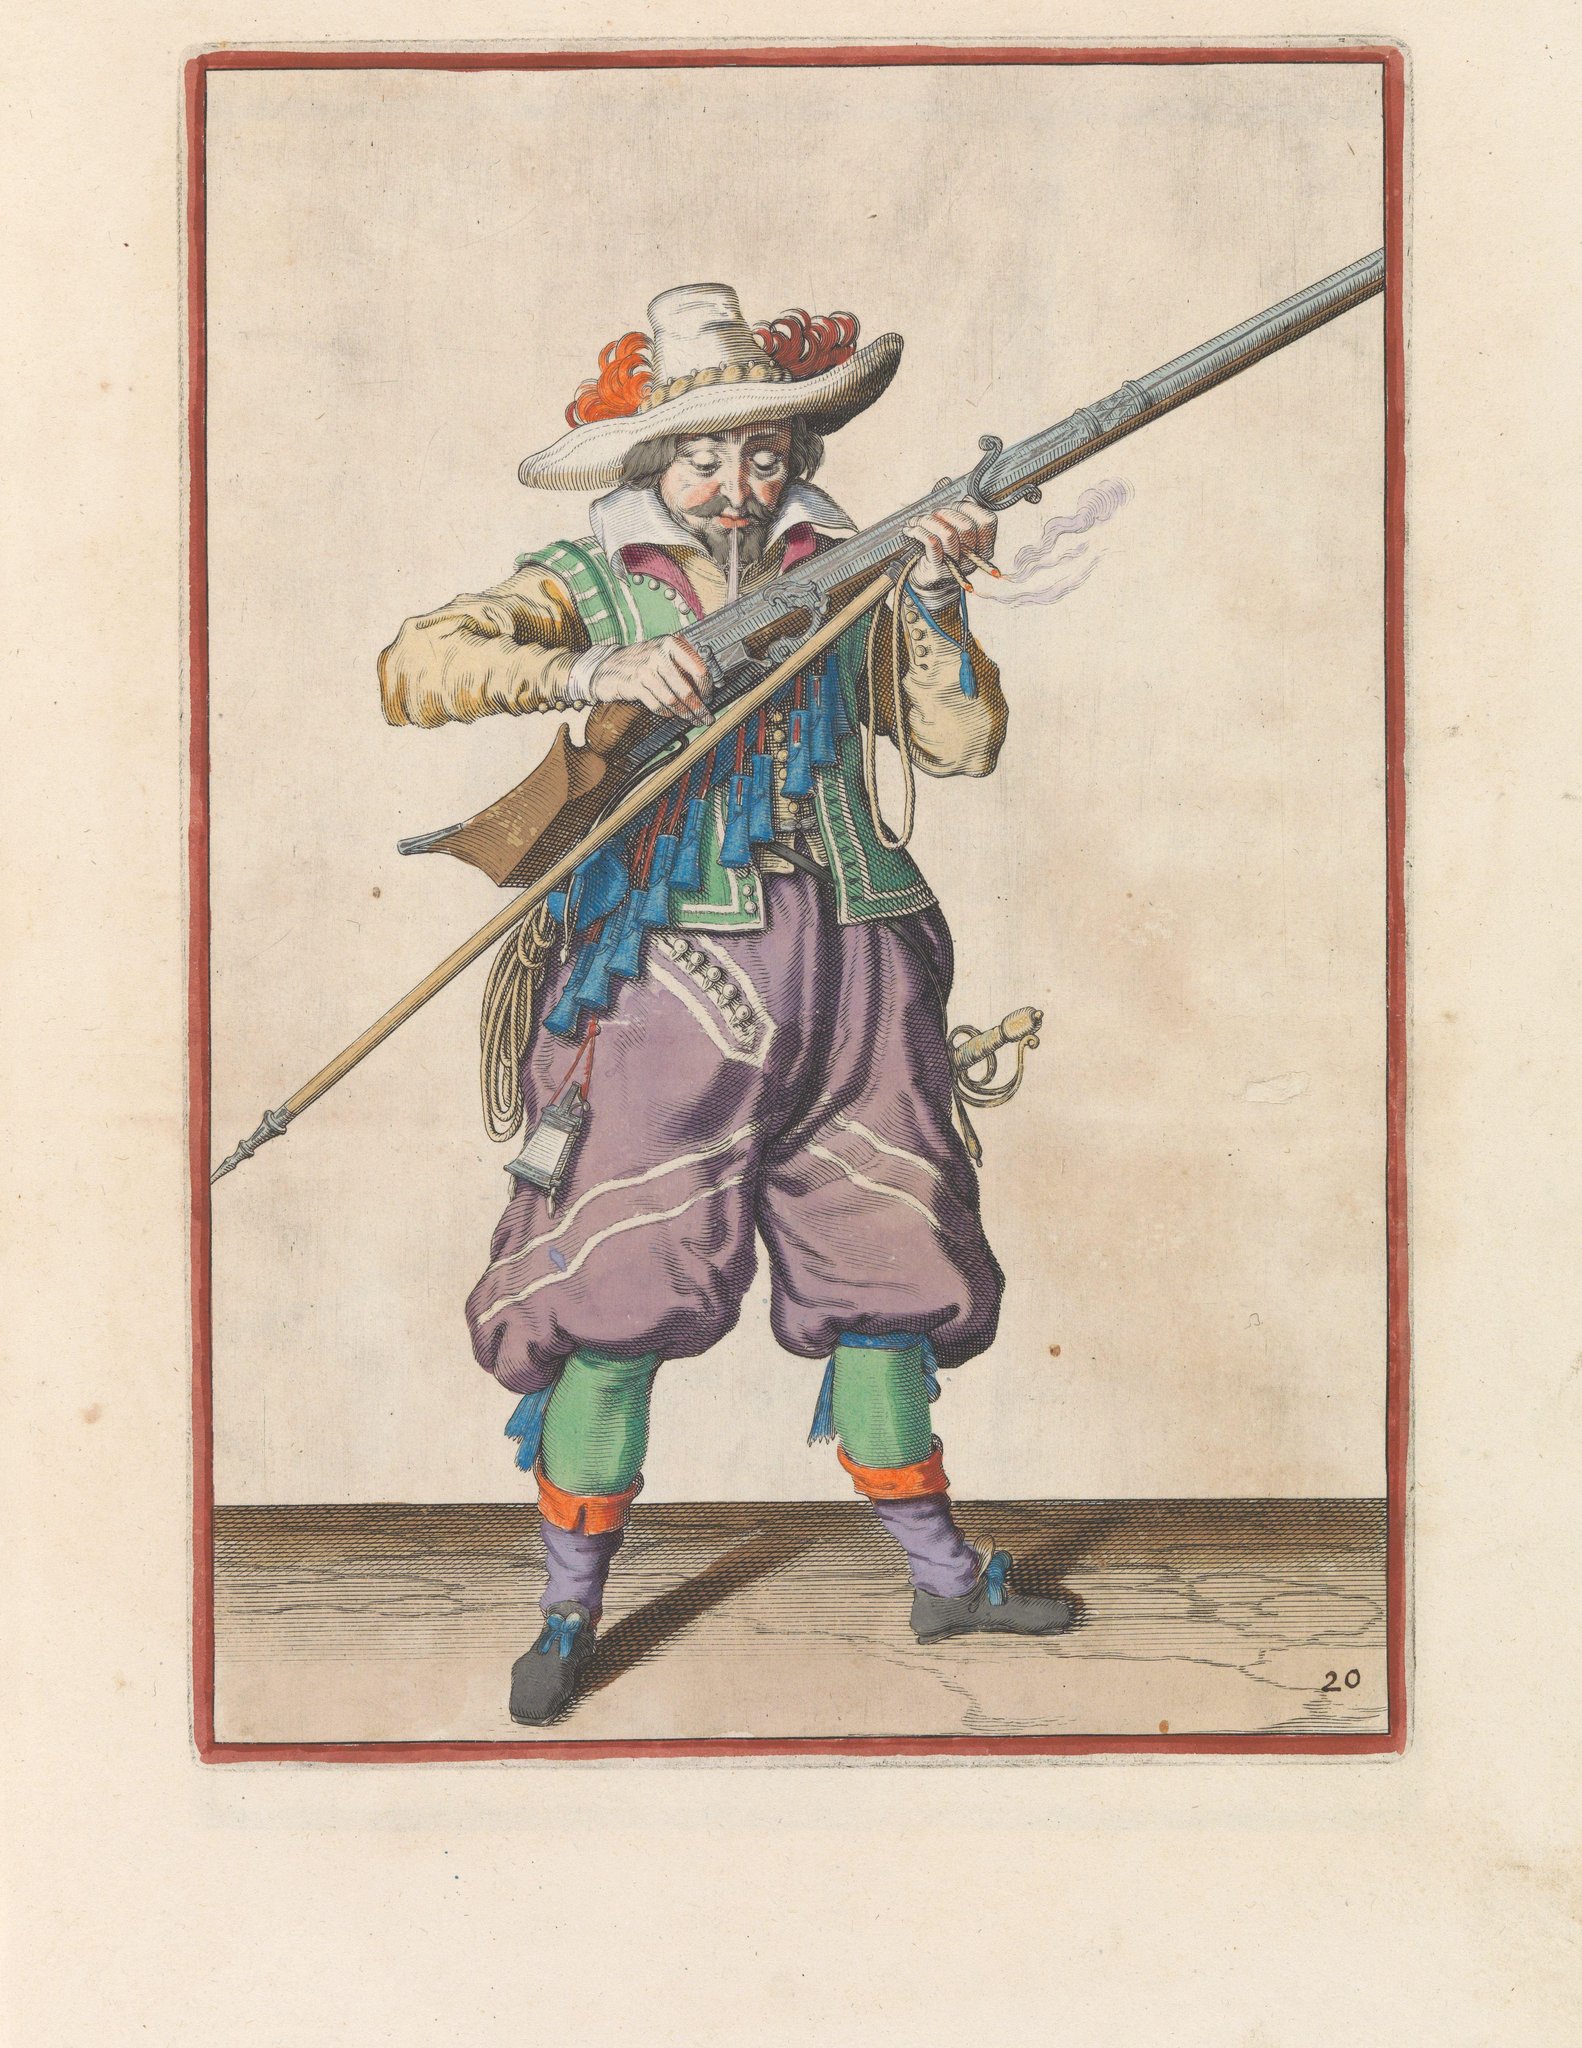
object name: print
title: Corte onderrechtinghe op de figuerliicke afbeeldinghe, soo veel aengaet het recht ghebruyck vant Musquet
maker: jacques de gheyn (ii)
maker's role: painter, print maker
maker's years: 1565-1629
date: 1597-1607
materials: paper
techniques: engraving, hand coloring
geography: the hague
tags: handling of weapons ~ military training, firearms: rifle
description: Een soldaat, ten voeten uit, die met beide handen een musket (een bepaald type vuurwapen) bij zijn mond houdt en erover blaast, om eventueel buiten de pan (het kruitreservoir) gevallen kruit ervan af te krijgen. In zijn linkerhand behalve de loop van het musket ook een furket (musketvork) en een brandende lont. Deze prent is onderdeel van de reeks van 43 met de hand genummerde prenten van musketiers in de Wapenhandelinghe.